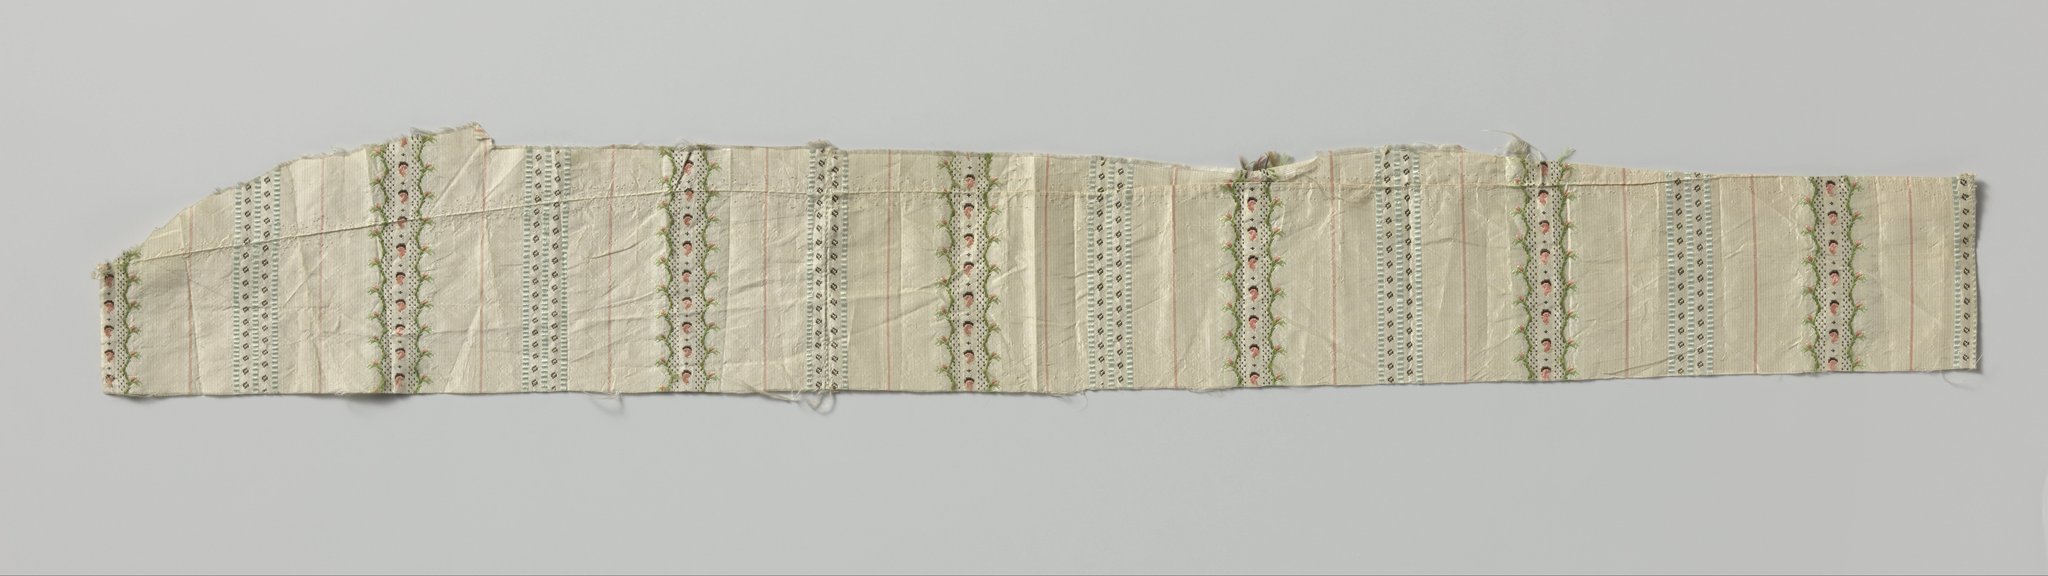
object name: fragment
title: Fragment gestreepte, veelkleurige zijden mexicaine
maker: Anonymous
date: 1775-1800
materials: silk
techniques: mexicaine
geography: netherlands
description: Fragment witte zijde met gekleurde strepen (vermoedelijk mouwgarneersel). Opmerking: Zelfkant; 5 mm in effenbinding. Bestaat uit drie banen van 44.5 cm. Zelfkanten aan de binnenzijde plus één zelfkant rechts naar binnen gevouwen.